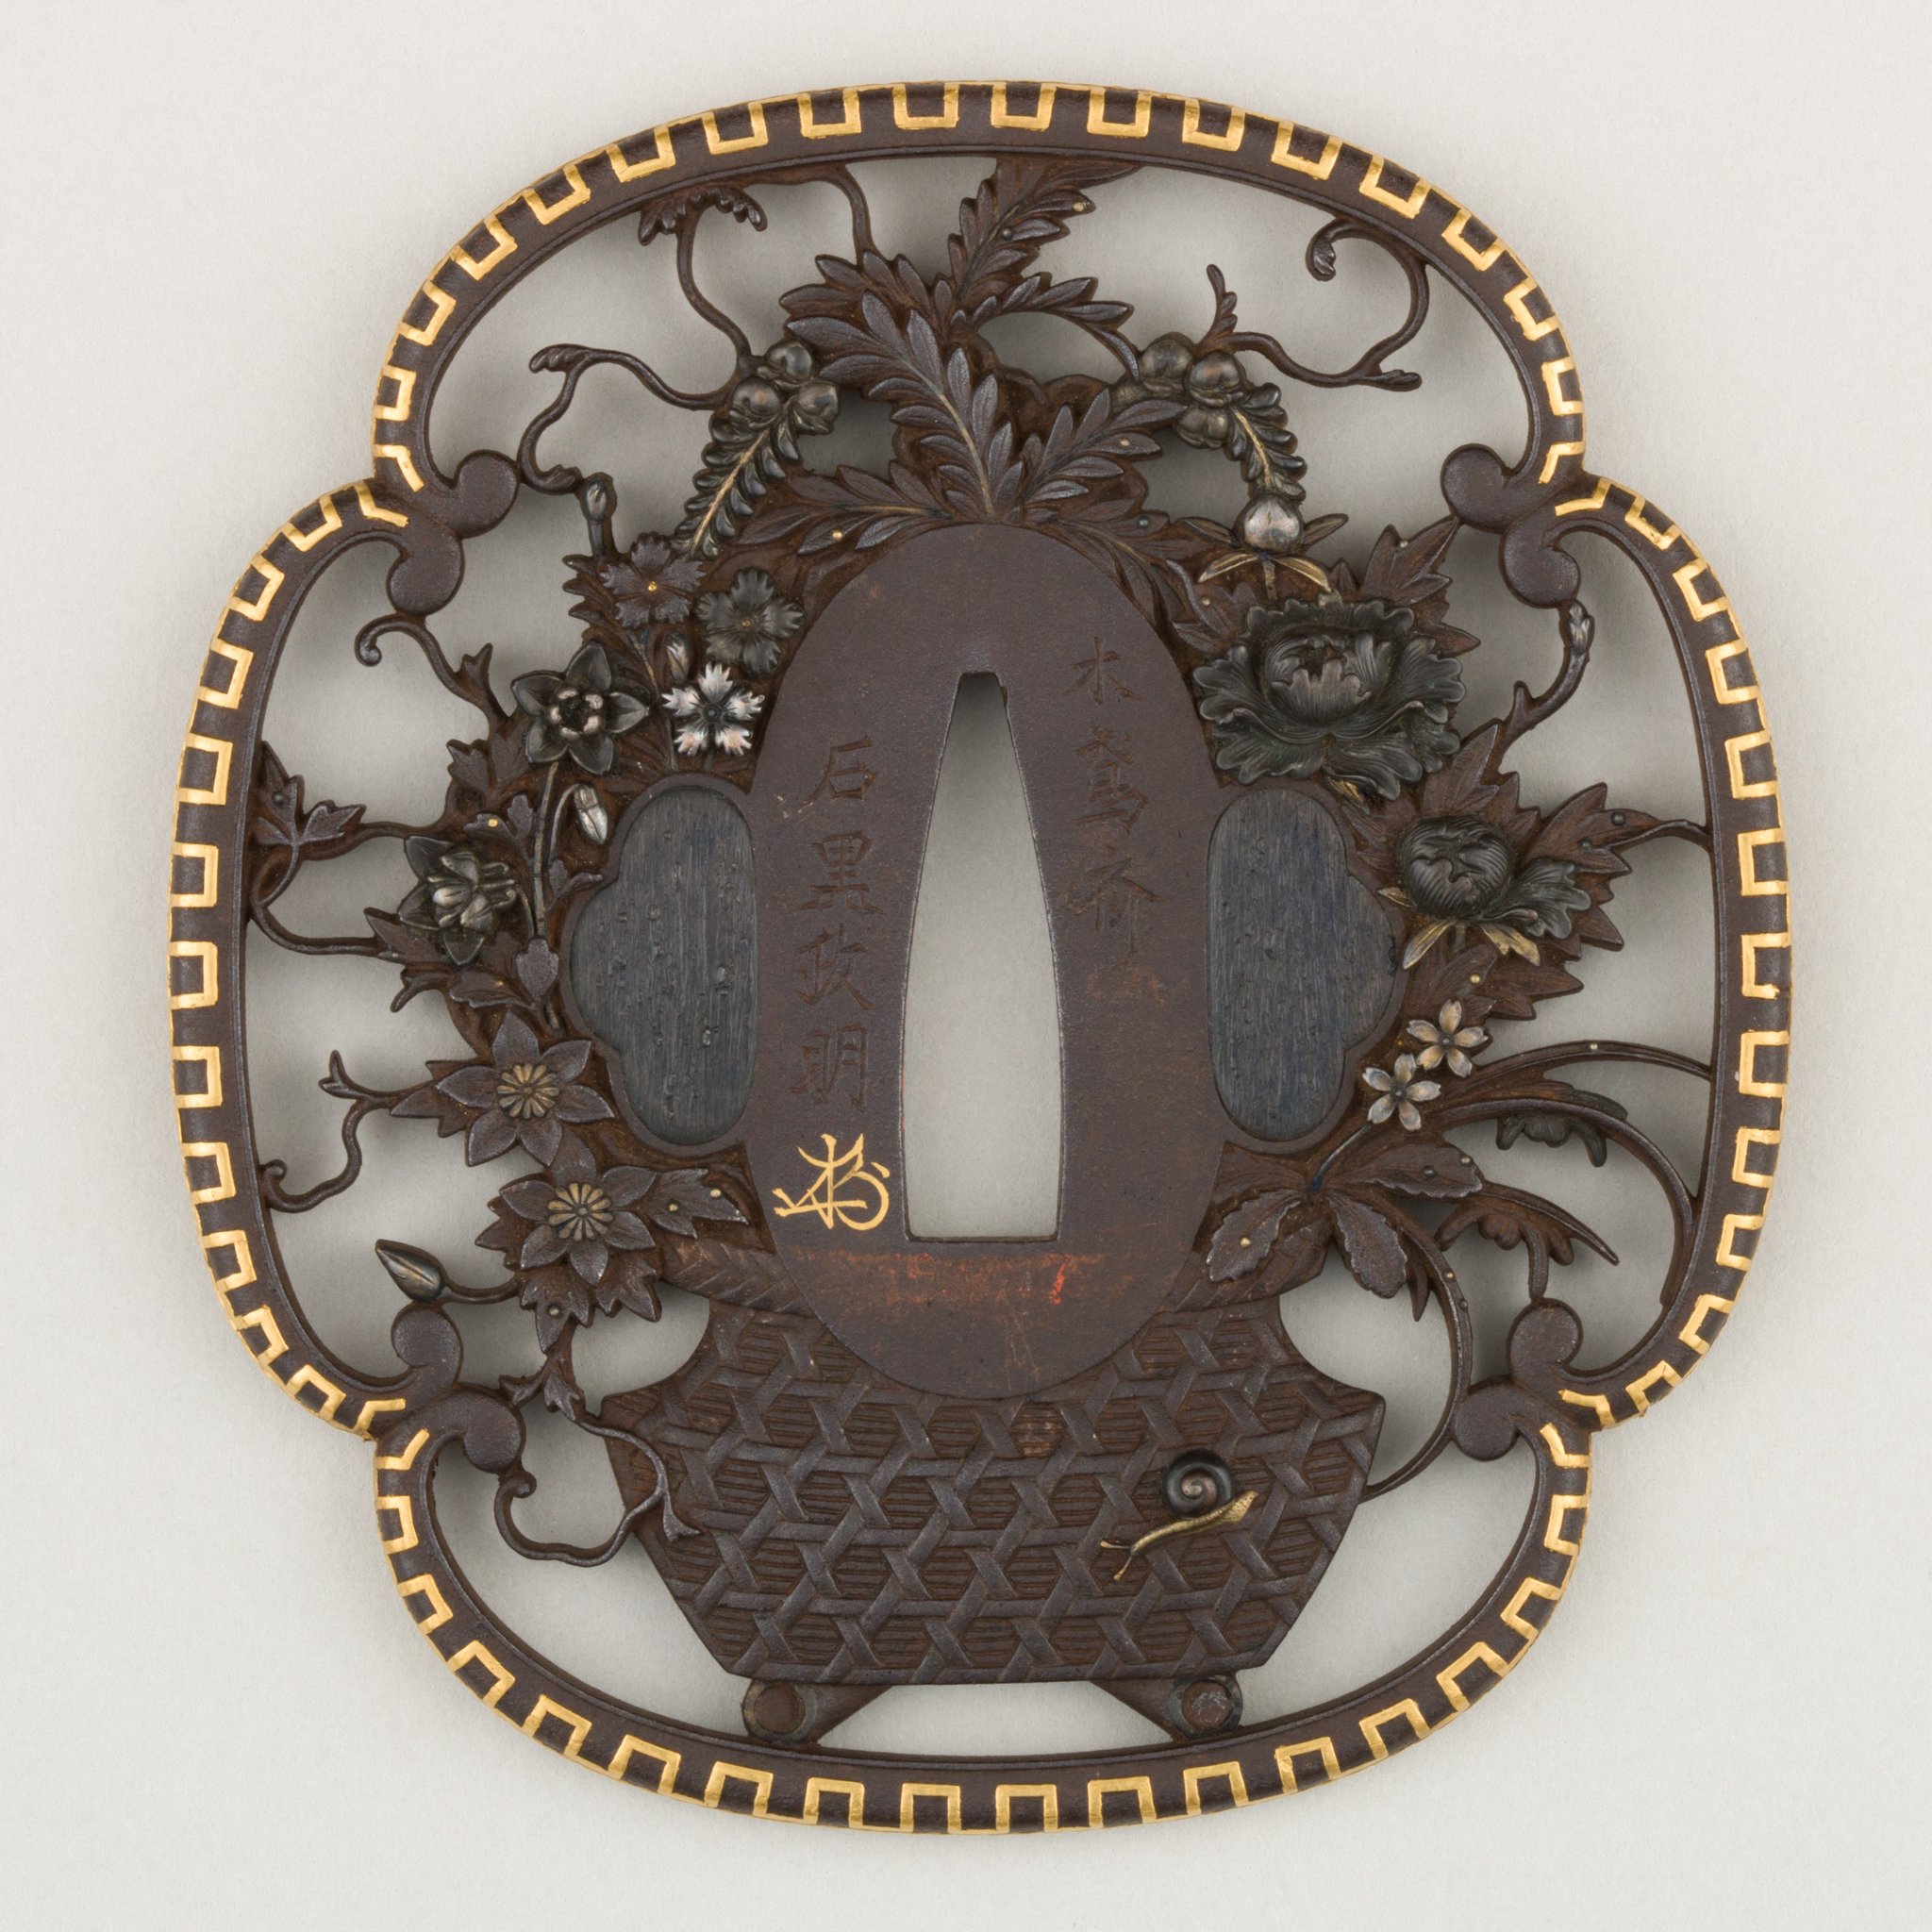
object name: sword guard tsuba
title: Sword guard (Tsuba) With Flower Basket Motif (花籠透鐔)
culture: japanese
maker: 石黒政明 ishiguro masaaki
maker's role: fittings maker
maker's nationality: japanese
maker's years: 1813-1880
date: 1801-1850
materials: copper, silver alloy, gold, iron, silver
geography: japan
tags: flowers